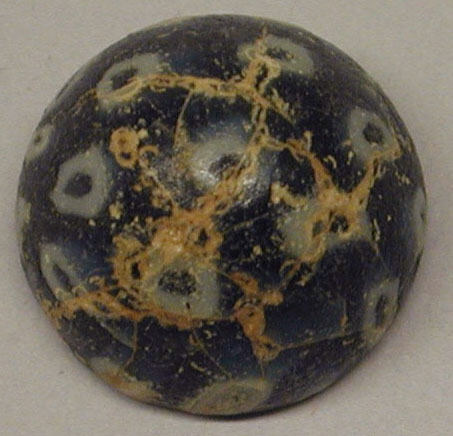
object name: gaming piece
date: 701-1200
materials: glass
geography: islamic lands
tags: games